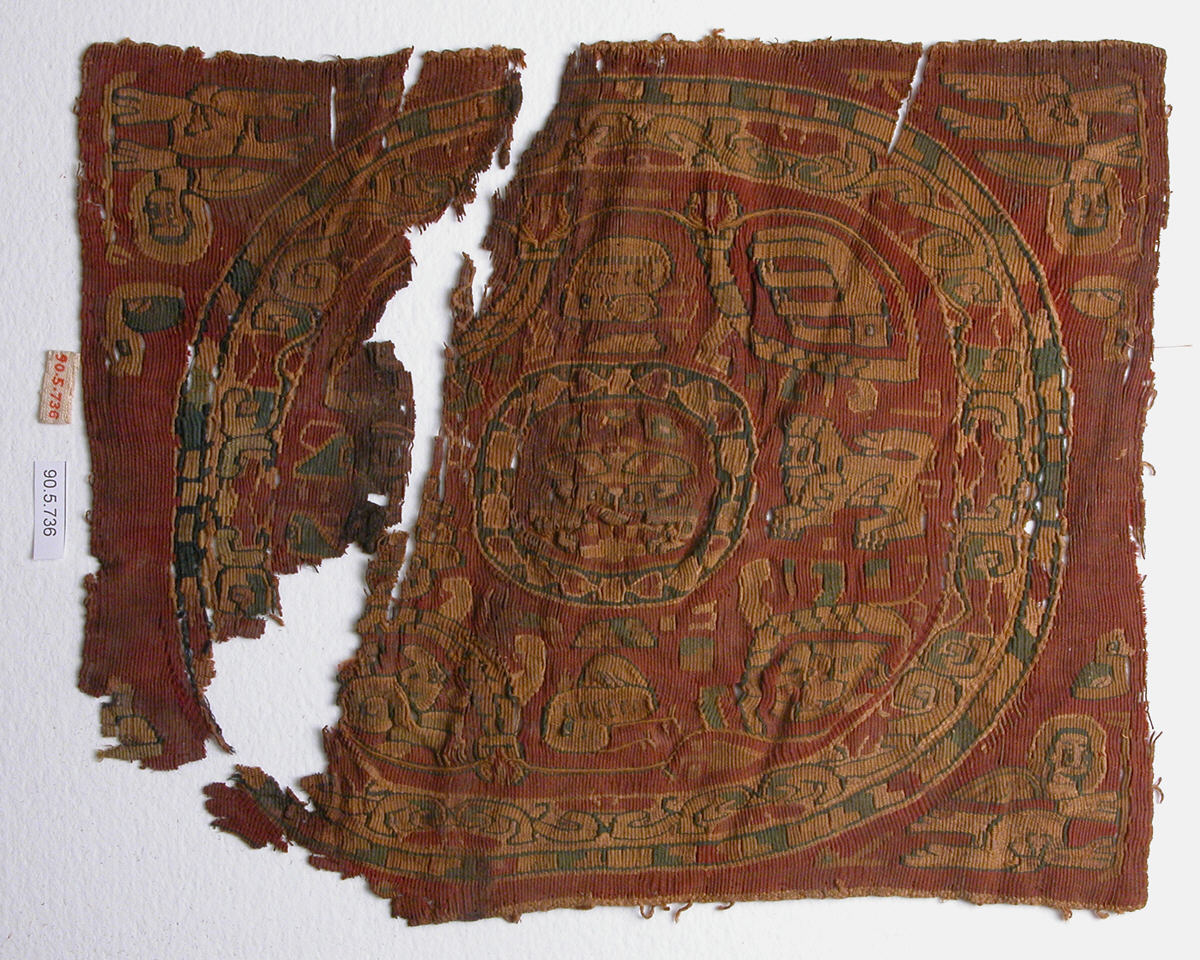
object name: textile fragment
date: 601-800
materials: linen, wool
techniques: weave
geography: egypt